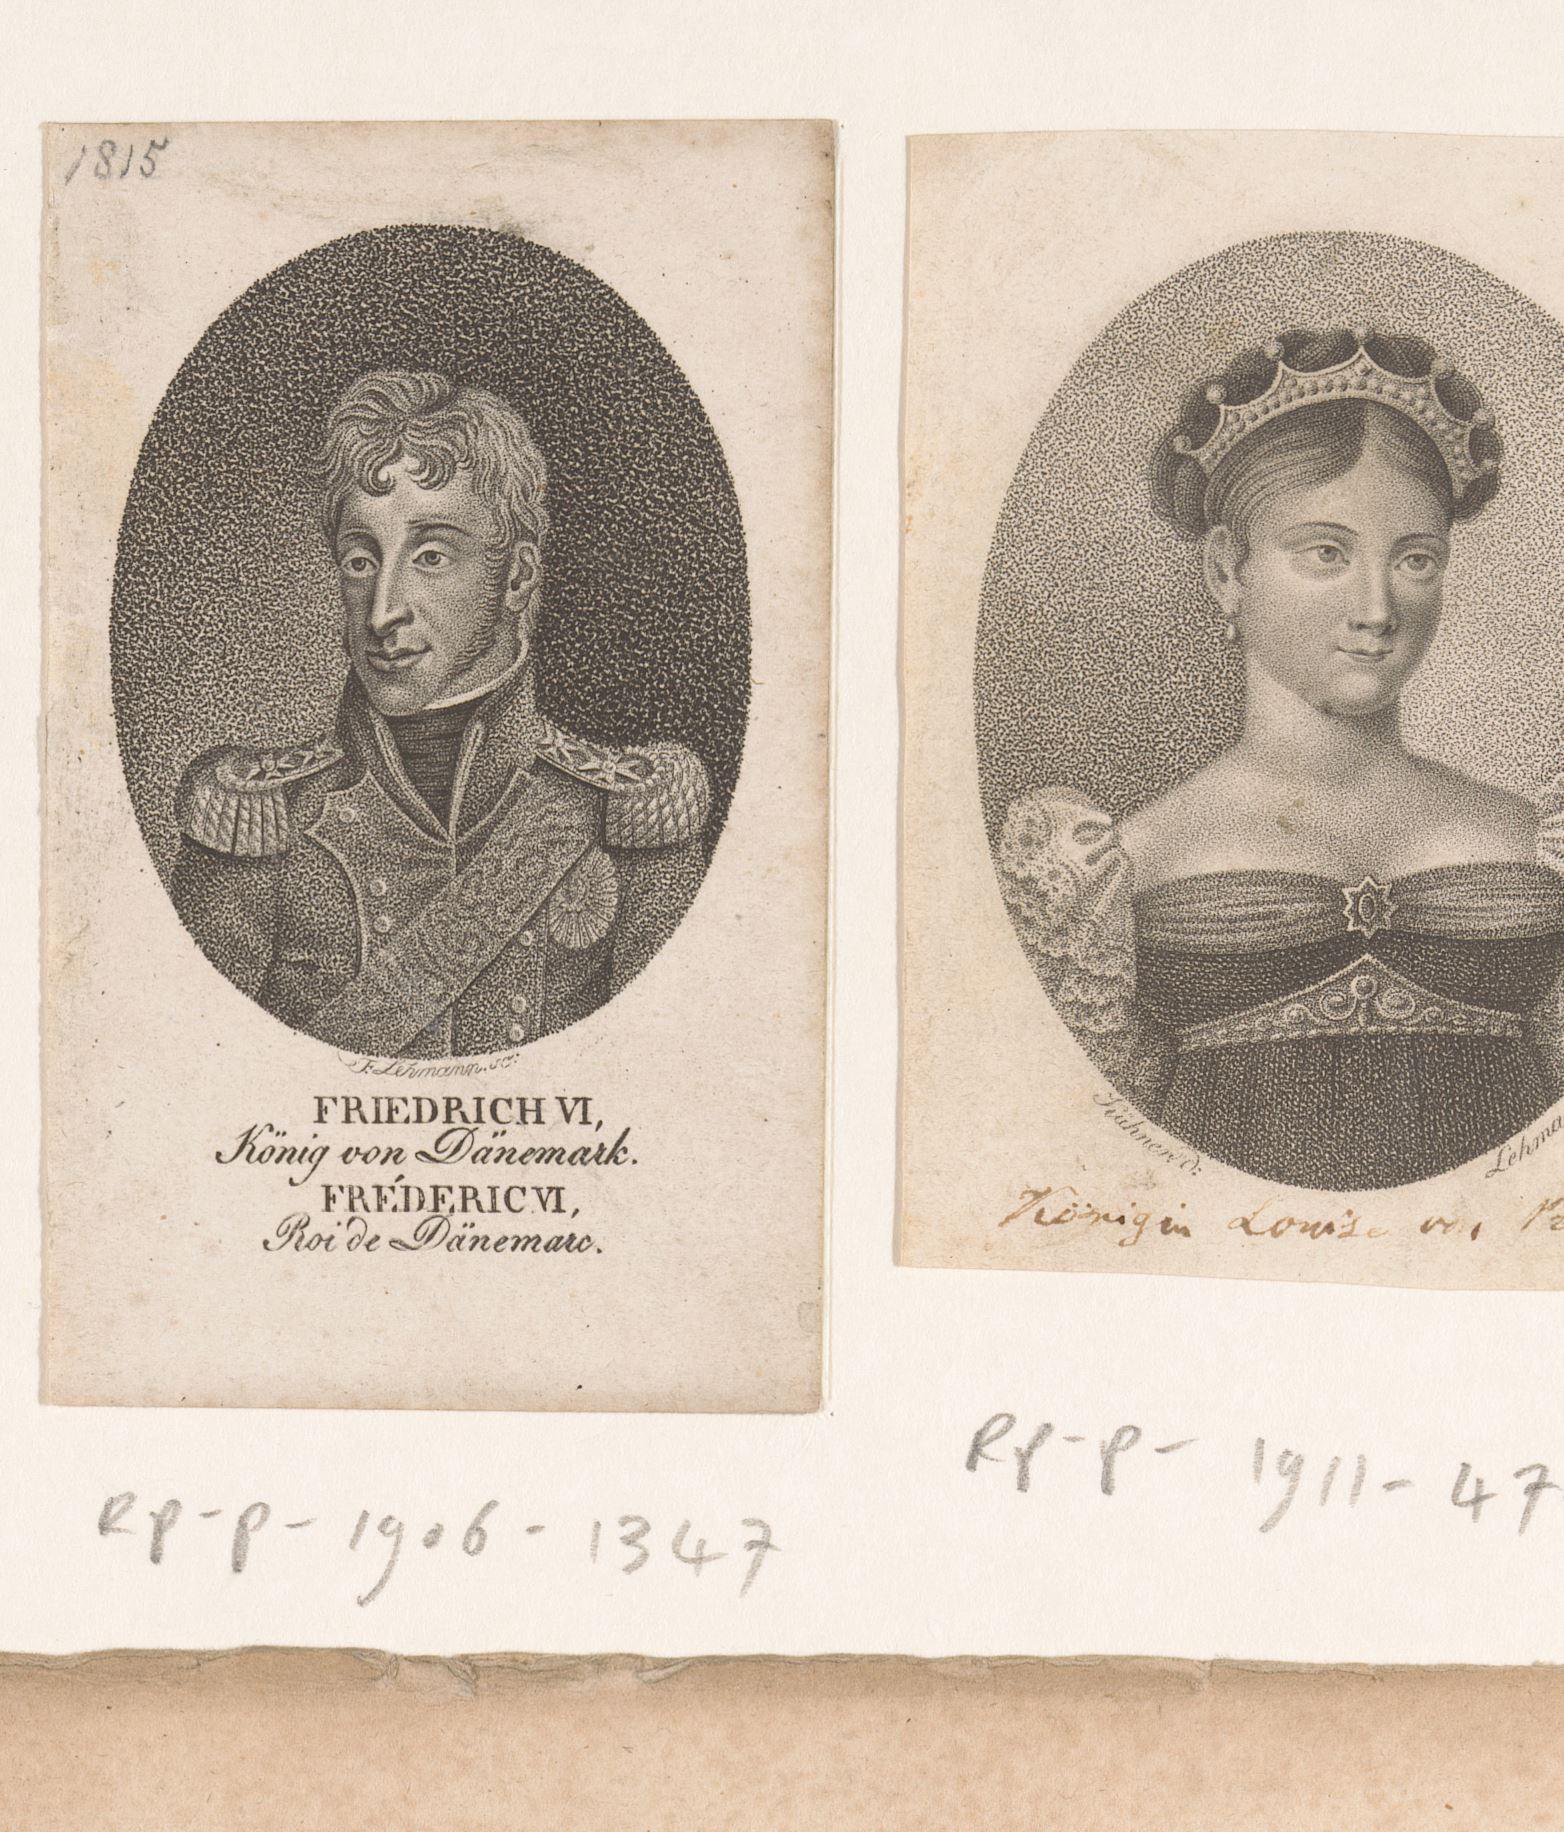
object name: print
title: Portret van Friedrich VI, koning van Denemarken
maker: friedrich leonhard lehmann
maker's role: print maker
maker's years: 1787-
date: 1797-1886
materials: paper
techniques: engraving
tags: historical persons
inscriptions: collector's mark: Lugt 2228, number: ‘1815’